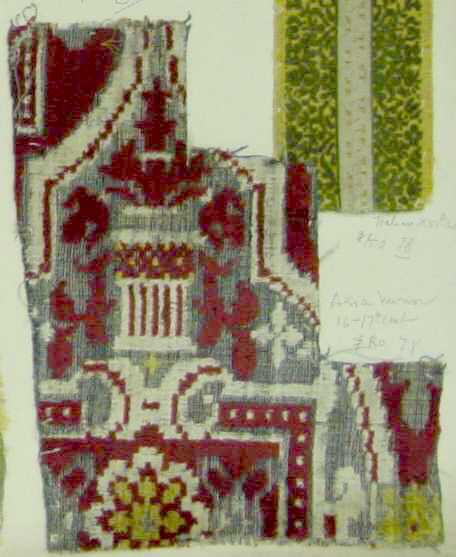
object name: textile fragment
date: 1501-1700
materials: metal thread, silk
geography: turkey